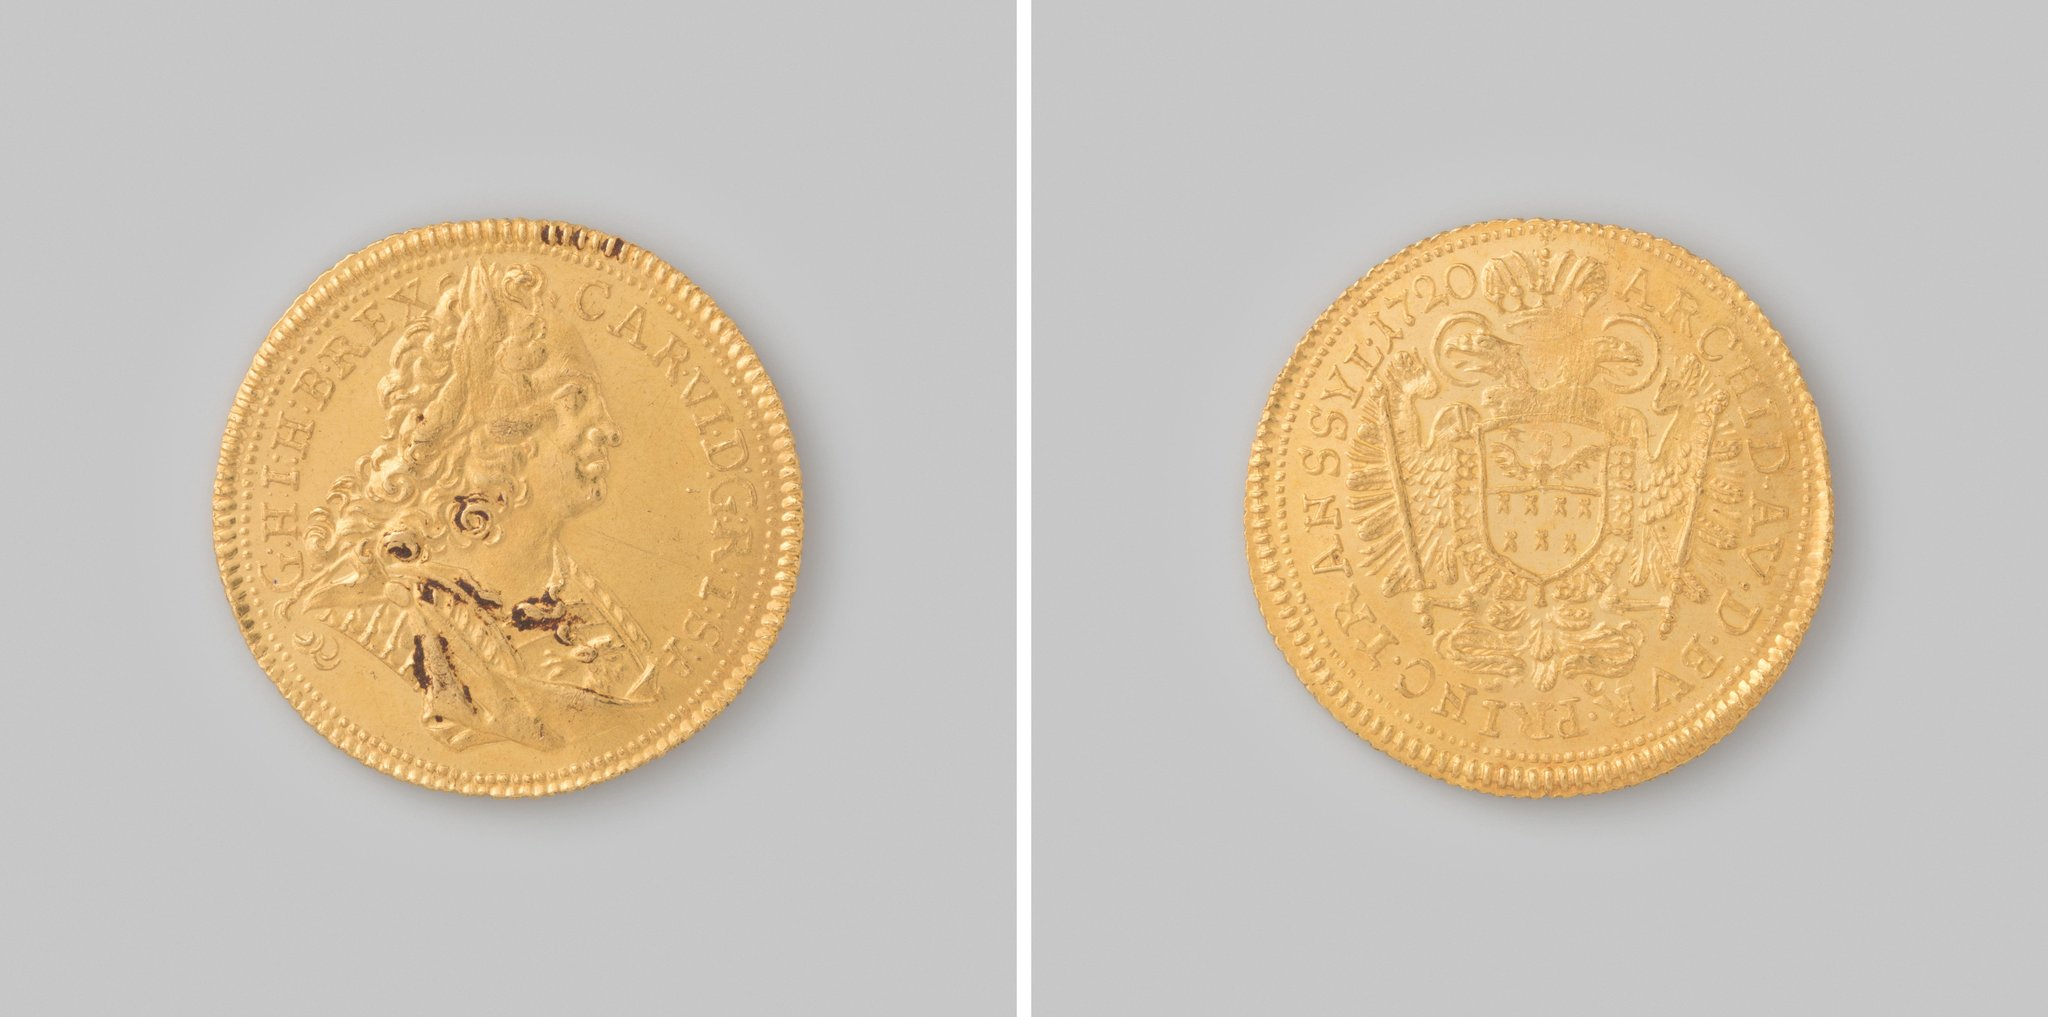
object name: coin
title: Dukaat uit Transsylvanië (Zevenbergen) van keizer Karel VI,1720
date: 1720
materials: gold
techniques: striking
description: Gouden munt. Voorzijde: hoofd van de keizer naar rechts. Keerzijde: gekroonde dubbelkoppige adelaar, met op zijn borst een door een ridderorde met juweel omhangen gekroond wapenschild van Transsylvanië en met in zijn poten zwaard en scepter. Jaartal aan het eind van het omschrift. Kabelrand.